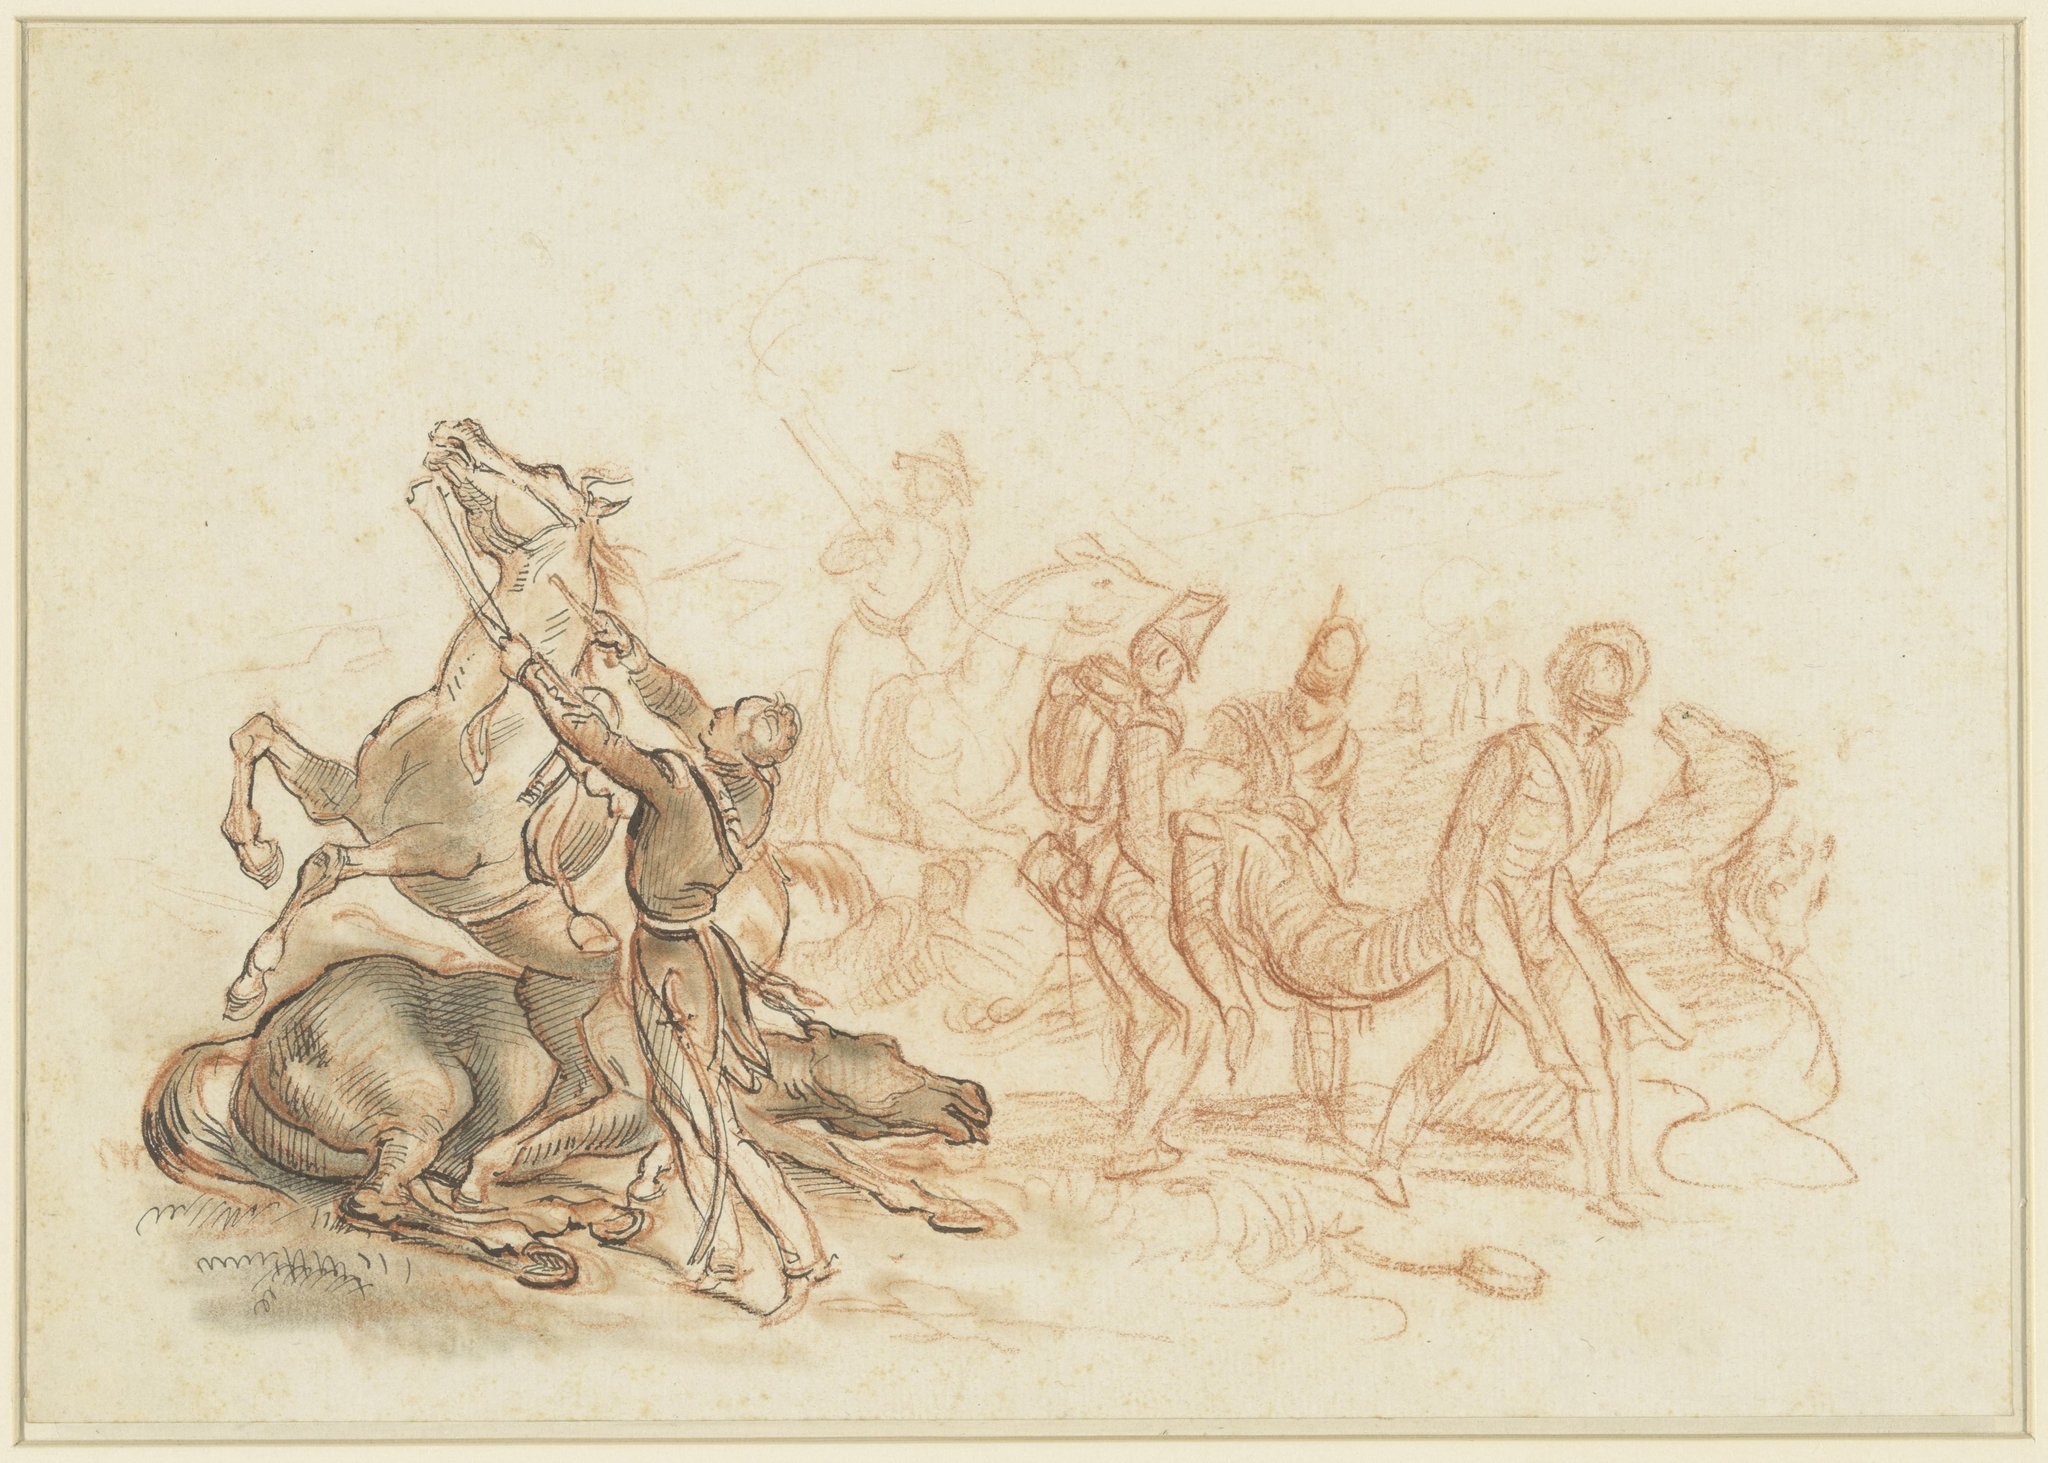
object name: design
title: Oorlogstafereel in Spanje: een gekwetst paard wordt met een pistoolschot afgemaakt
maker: horace vernet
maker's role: draughtsman, painter, print maker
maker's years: 1789-1863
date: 1799-1863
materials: chalk, ink, paper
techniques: brush, pen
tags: horse (+ animal killed by man), battle, carrying the sick, wounded and dead off the battle-field, after the battle